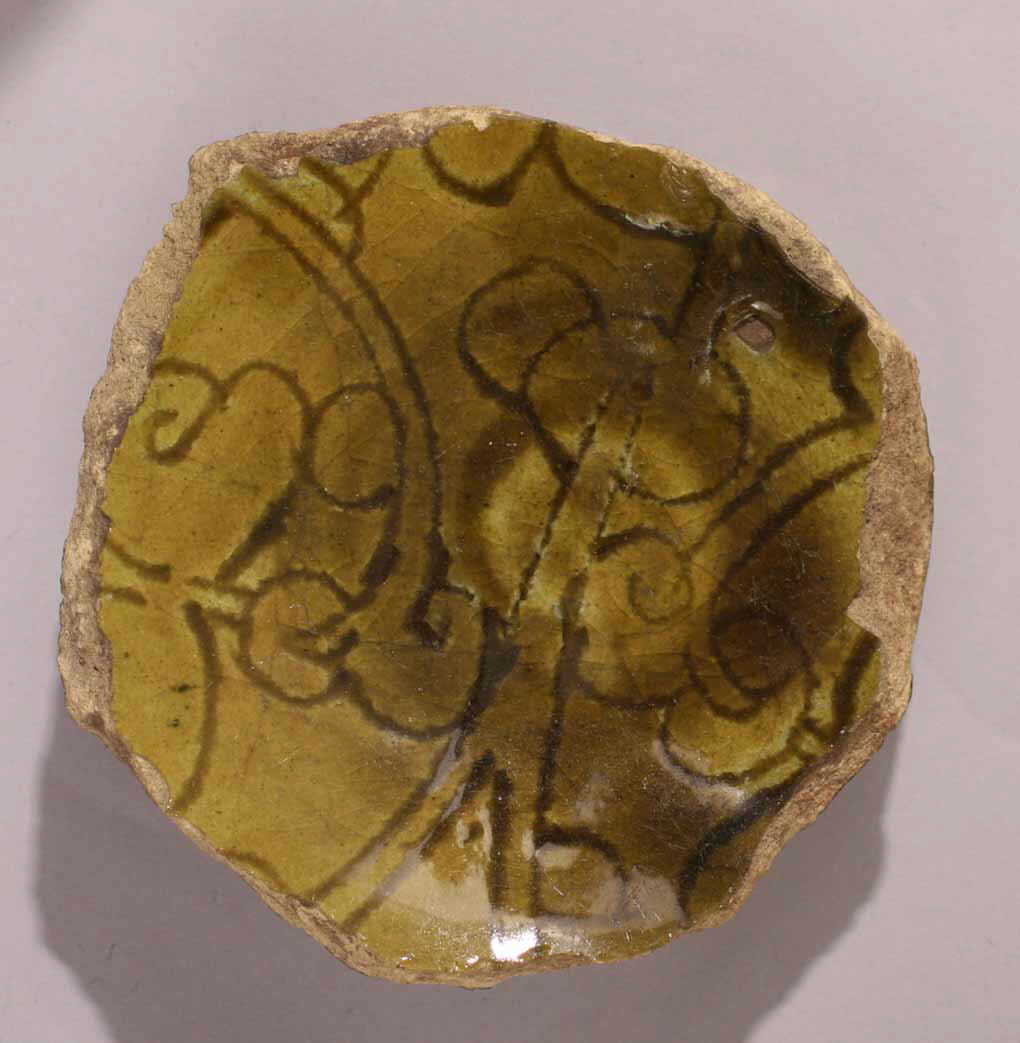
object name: ceramic fragment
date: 1201-1400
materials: earthenware, glaze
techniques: coloring, incising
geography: egypt